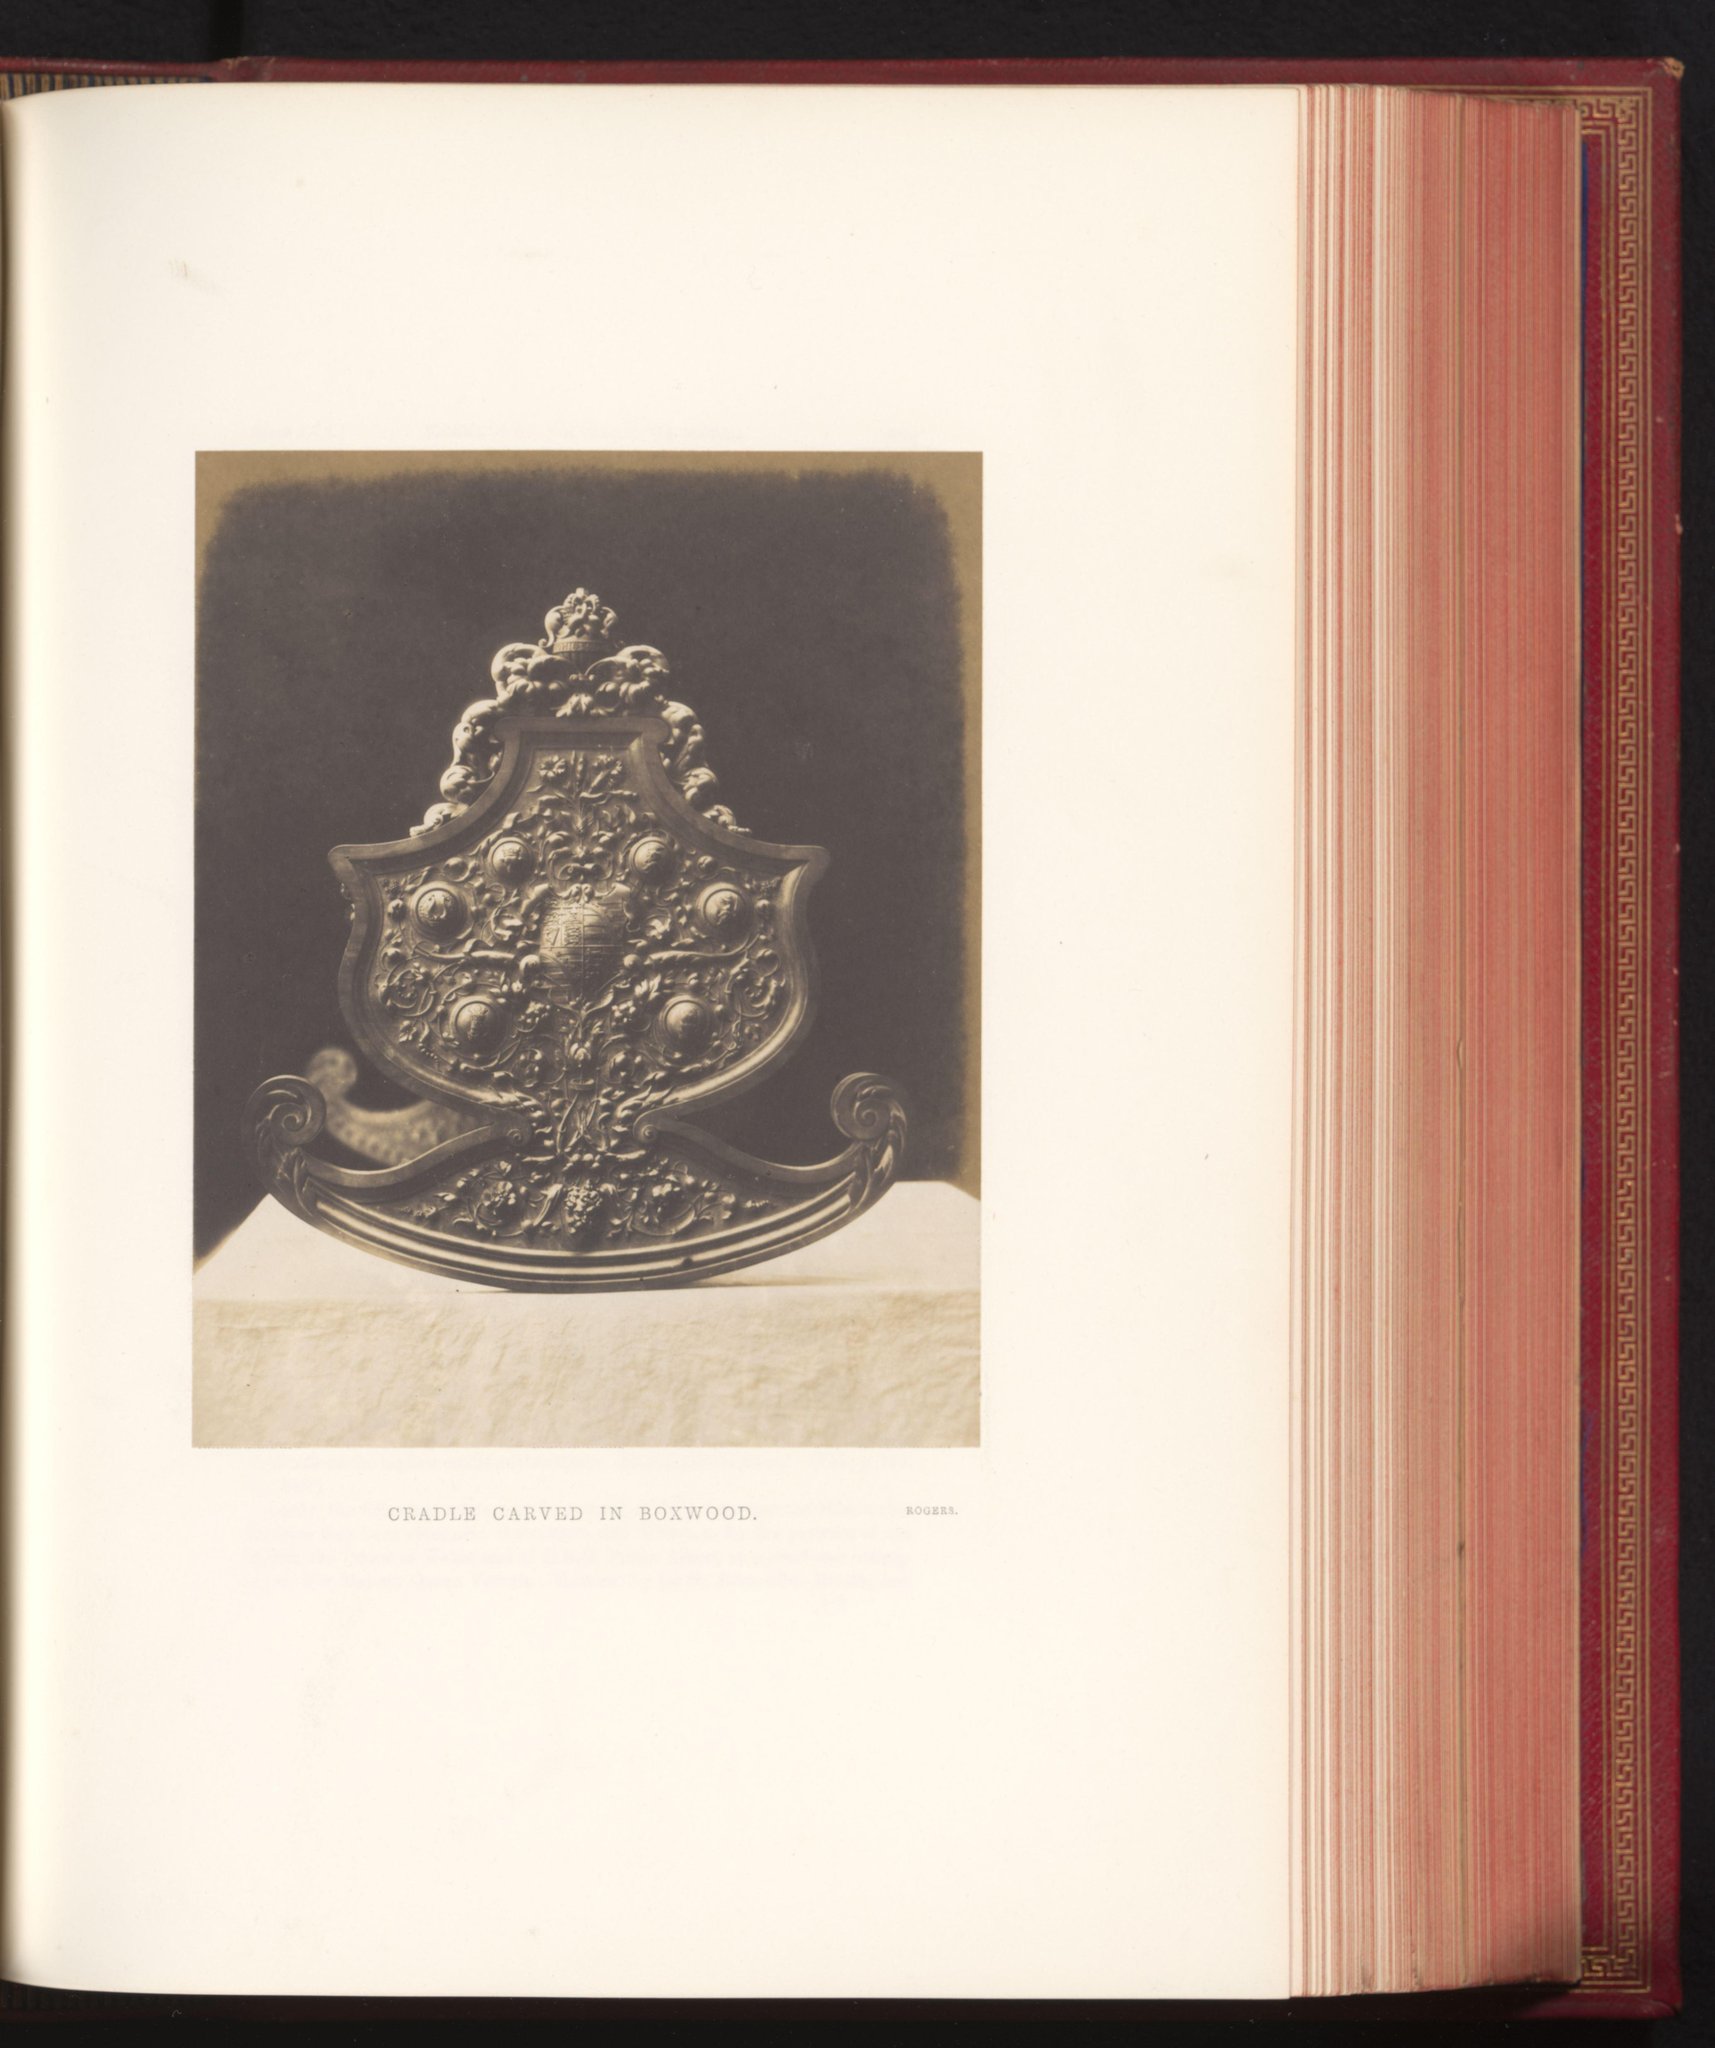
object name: photograph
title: Cradle Carved in Boxwood. Rogers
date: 1851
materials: photographic support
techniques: salted paper print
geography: london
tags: cradle, crib, london